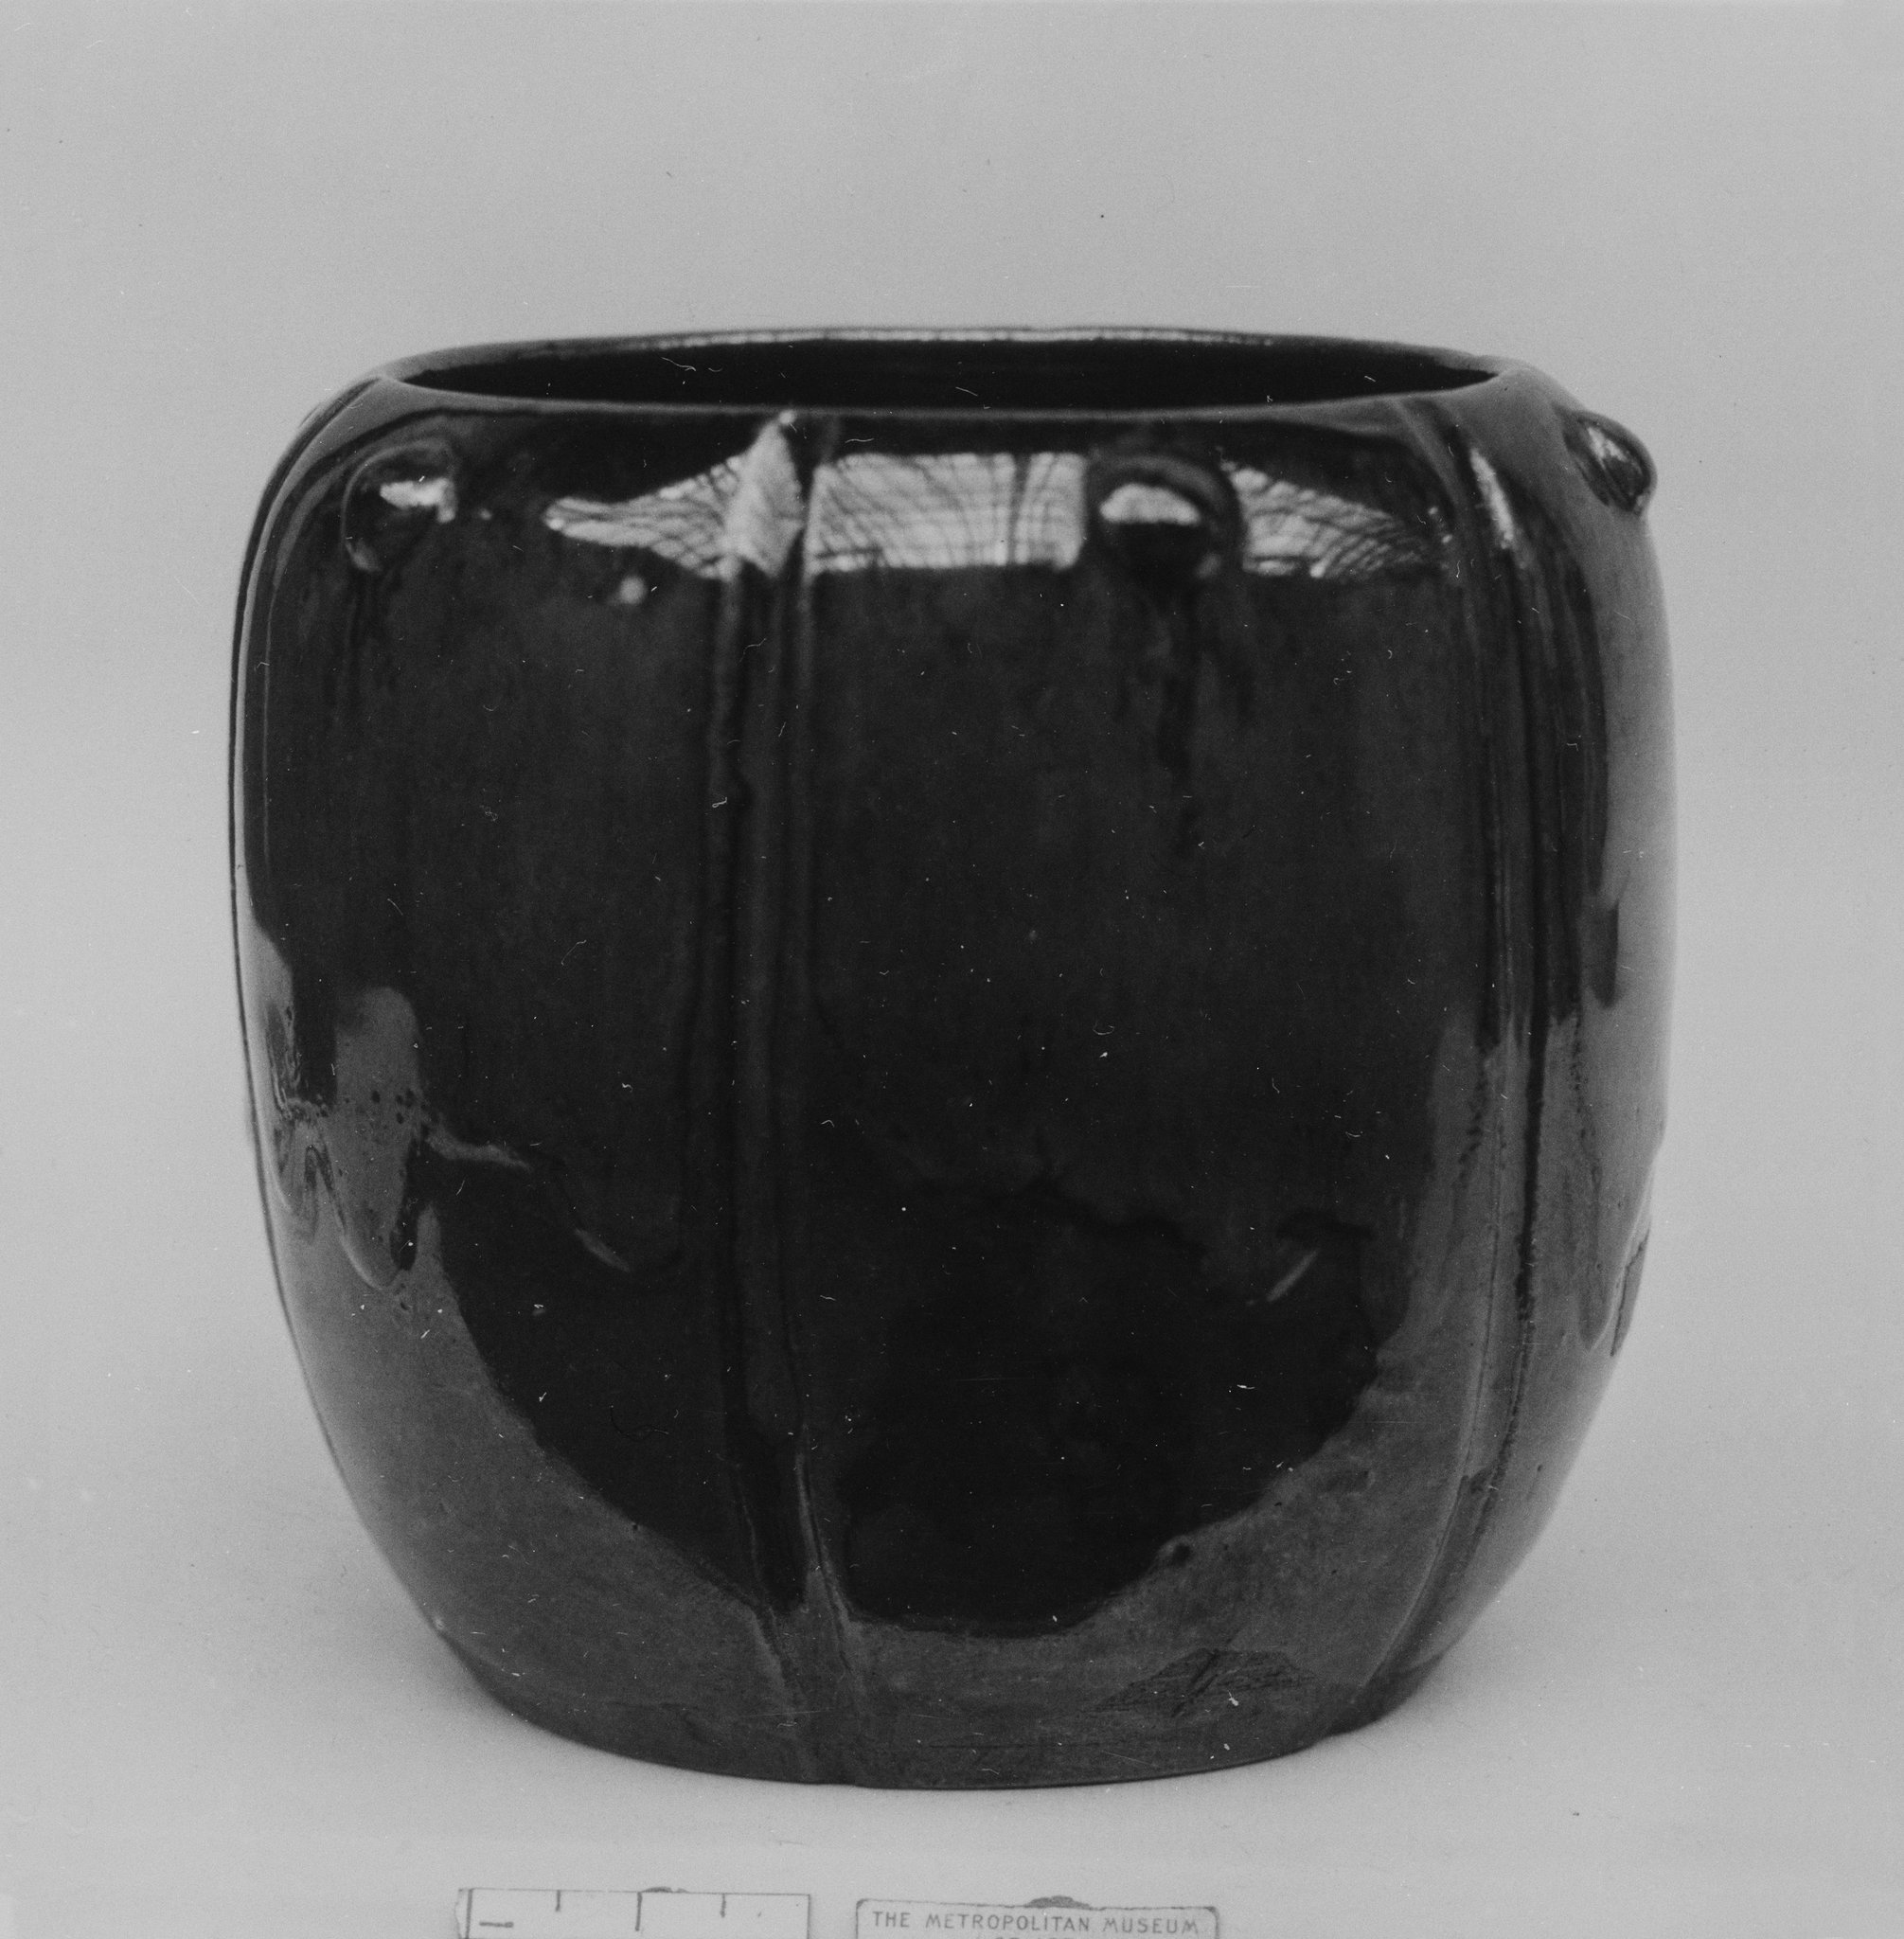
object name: jar or fire holder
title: Jar or Fire-holder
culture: japanese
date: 1840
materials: glaze, iron, pottery